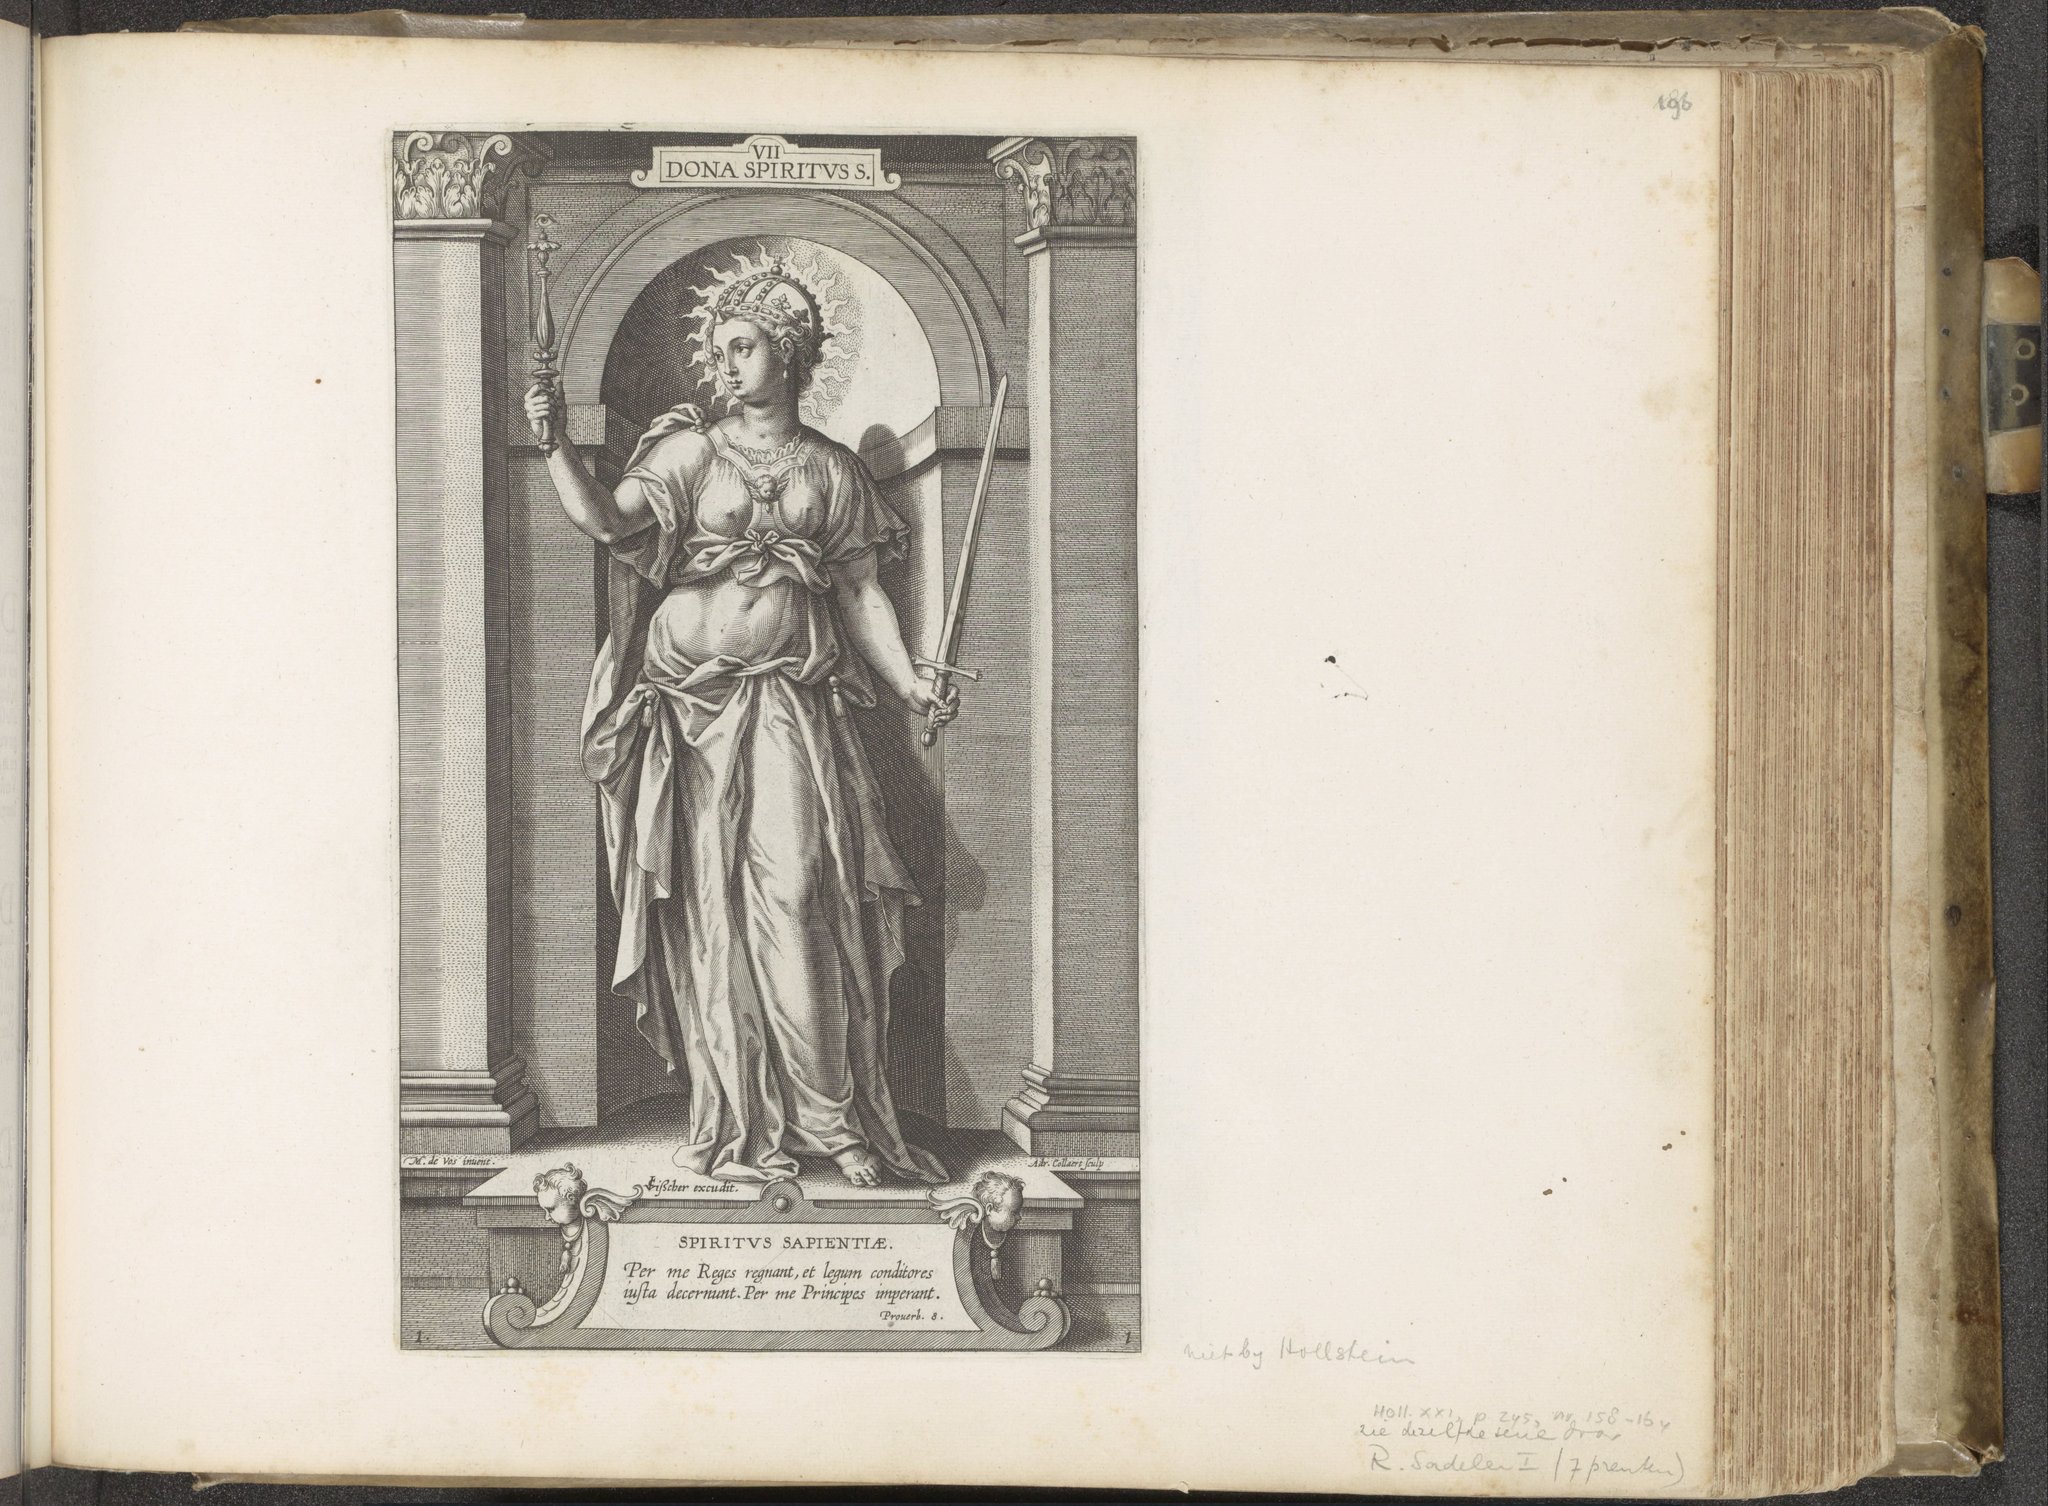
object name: print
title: Septem Dona Spiritus Sancti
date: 1653-1654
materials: paper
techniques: engraving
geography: amsterdam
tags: 'sapientia', wisdom; 'sapienza divina' (ripa) ~ one of the seven gifts of the holy ghost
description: In een nis de vrouwelijke personificatie van de gave van wijsheid, een van de zeven gaven van de Heilige Geest. Ze draagt een kroon en in haar handen heeft ze een scepter en een zwaard. Onderaan de Bijbeltekst uit Spreuken 8:15-16 in het Latijn. De prent maakt deel uit van een album.